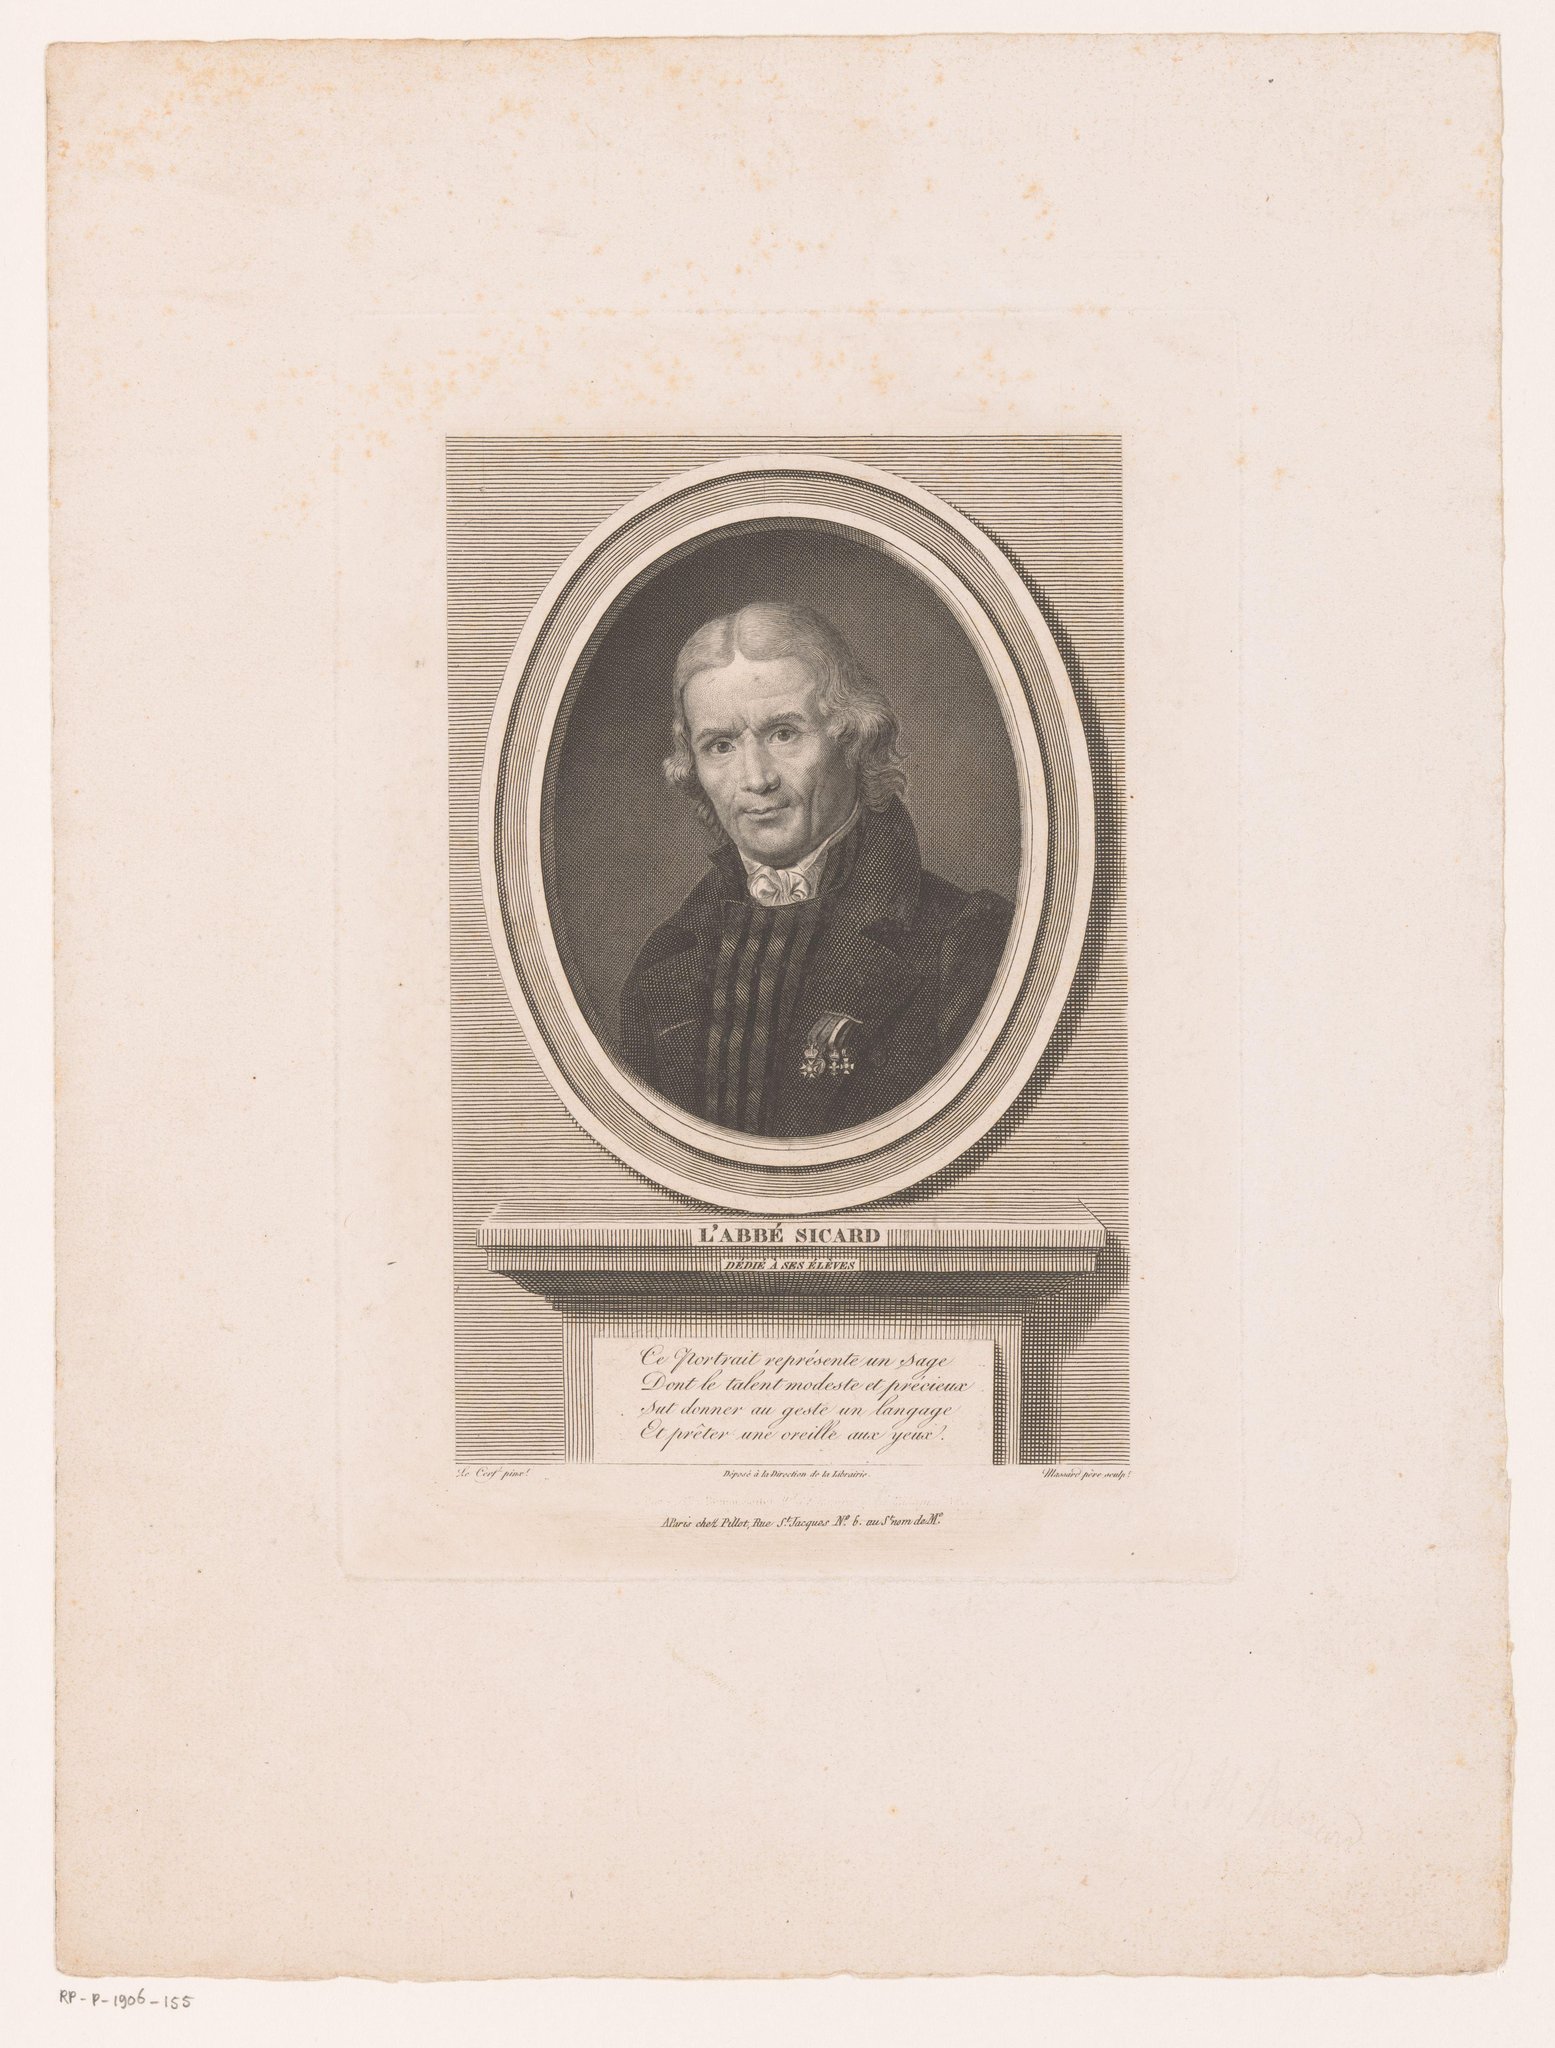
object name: print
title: L'Abbé Sicard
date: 1750-1822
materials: paper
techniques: engraving, etching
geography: paris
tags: clergyman, historical persons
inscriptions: dedication: ‘Dédié à ses élèves’, collector's mark: Lugt 2228, : ‘Déposé à la Direction de la librairie.’